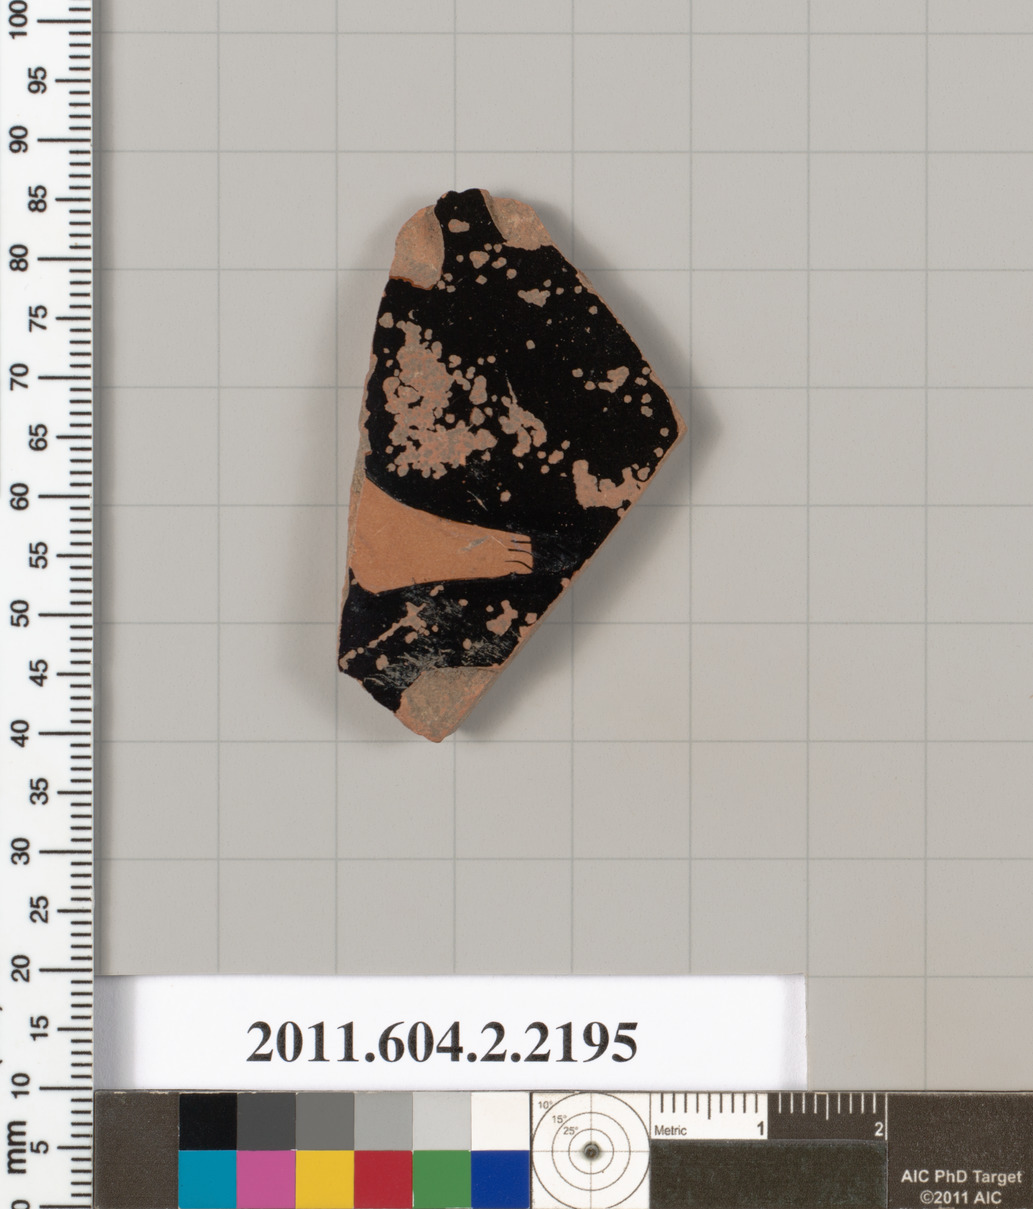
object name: pot fragment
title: Terracotta fragment of a pot; unglazed on the inside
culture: greek, attic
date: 450-426 BCE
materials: terracotta